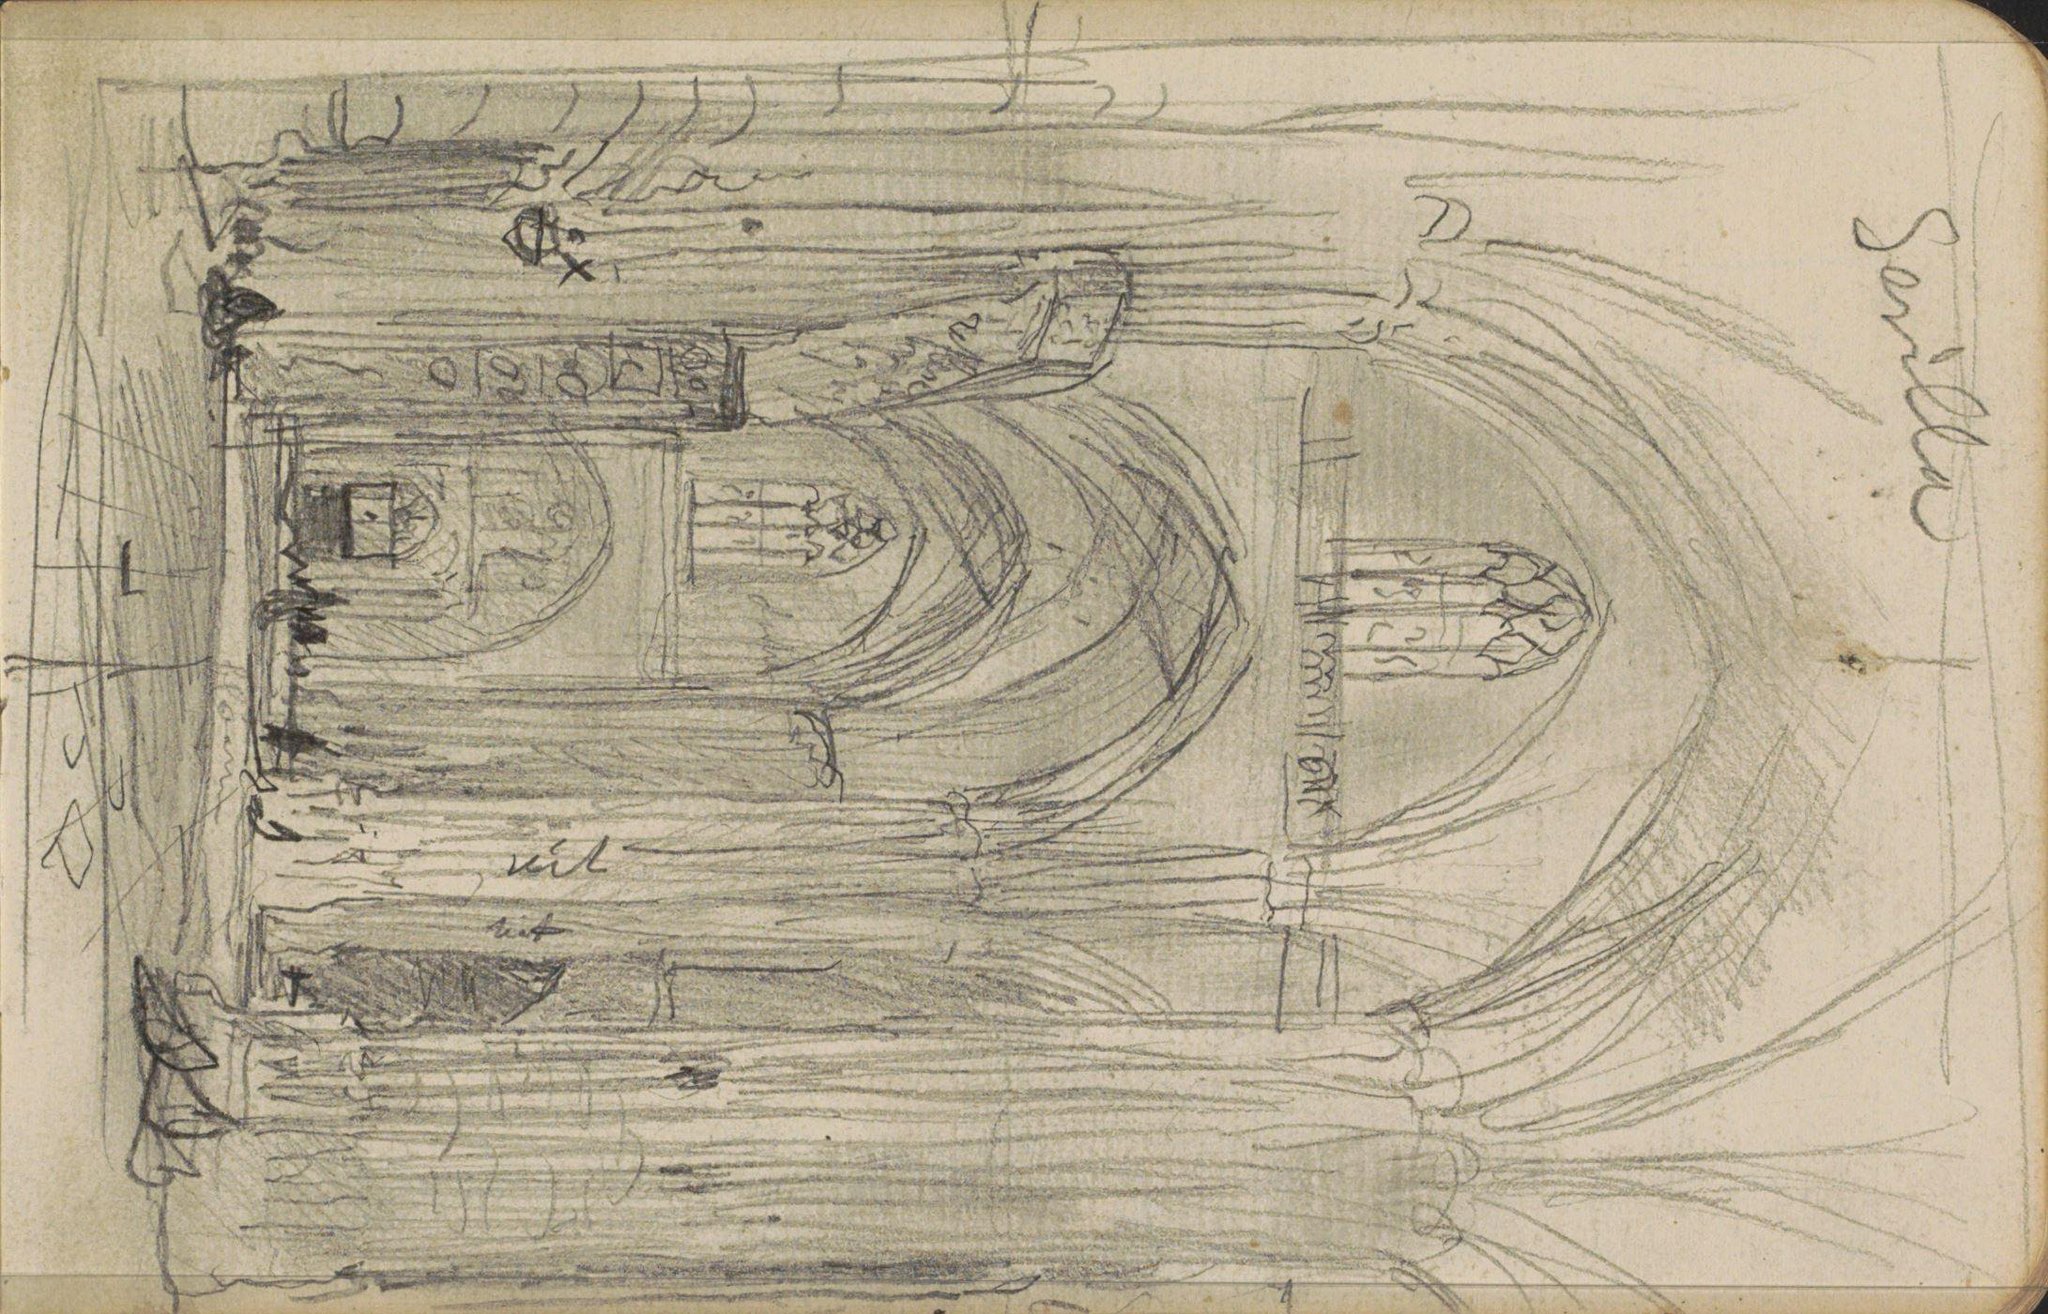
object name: sketchbook leaf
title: Interieur van de kathedraal van Sevilla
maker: marius bauer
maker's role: draughtsman, print maker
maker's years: 1867-1932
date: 1902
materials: paper, pencil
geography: sevilla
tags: interior of church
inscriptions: annotation: ‘Sevilla’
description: Pagina 17 uit een schetsboek met 30 bladen.